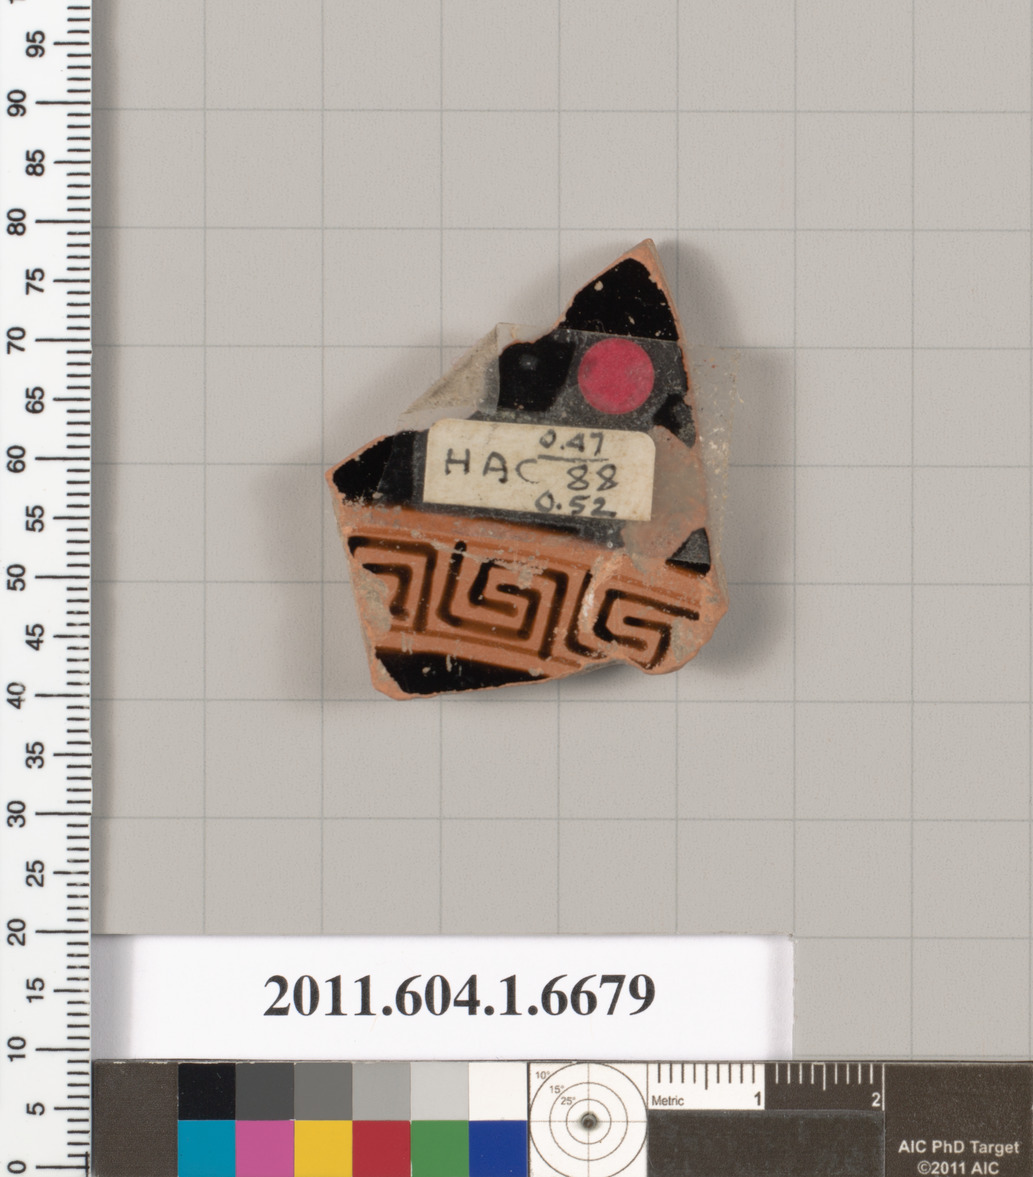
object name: kylix fragment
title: Terracotta fragment of a kylix (drinking cup)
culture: greek, attic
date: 490-470 BCE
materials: terracotta